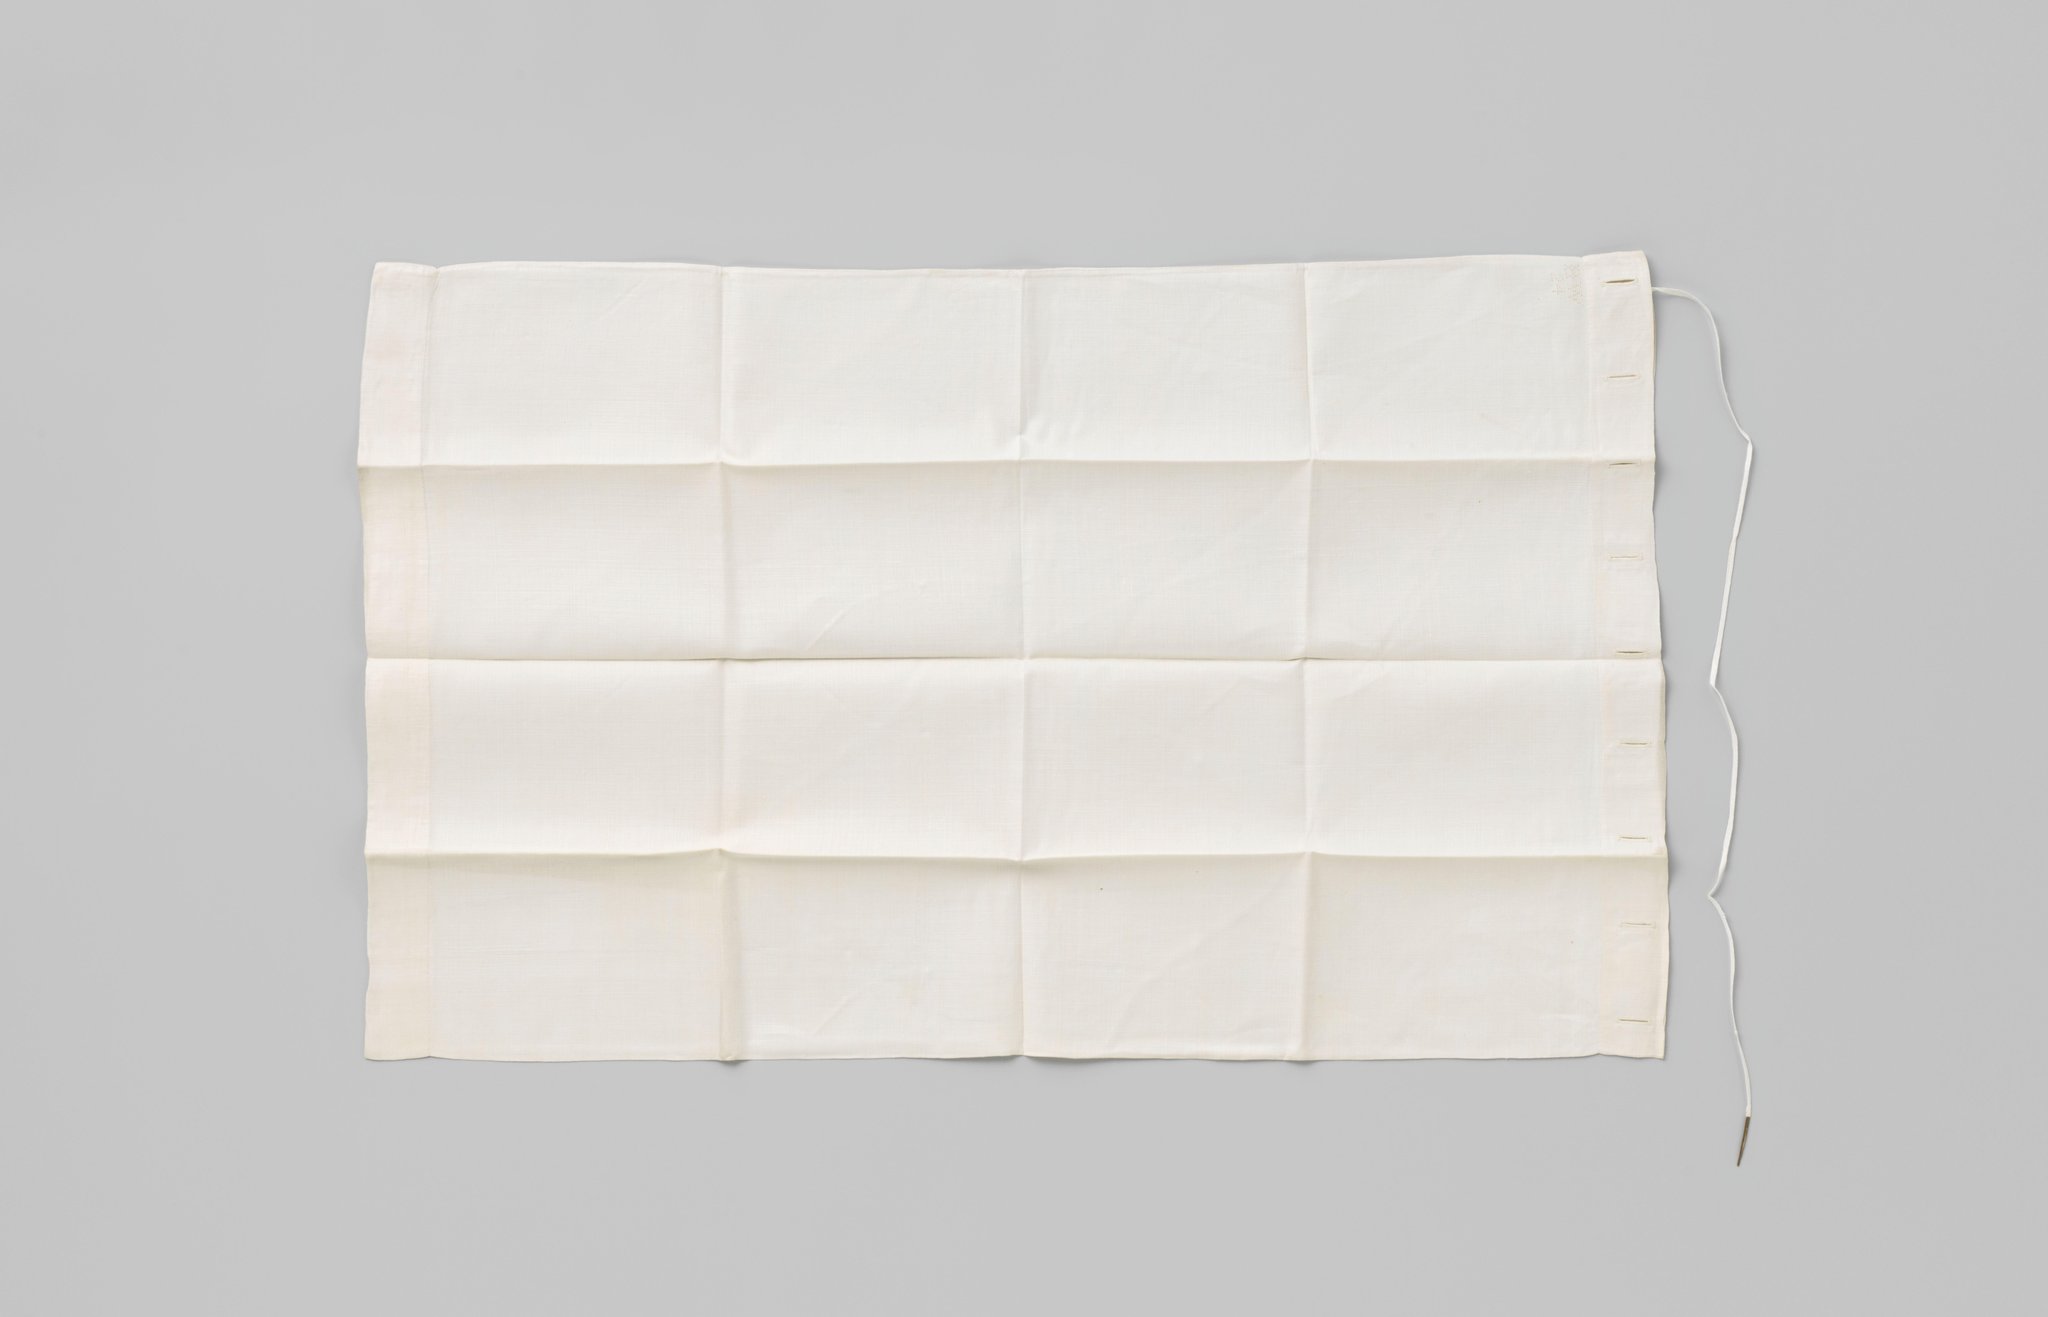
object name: sloop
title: Lendensloop met merk HW 24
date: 1820-1850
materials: linen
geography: northern netherlands